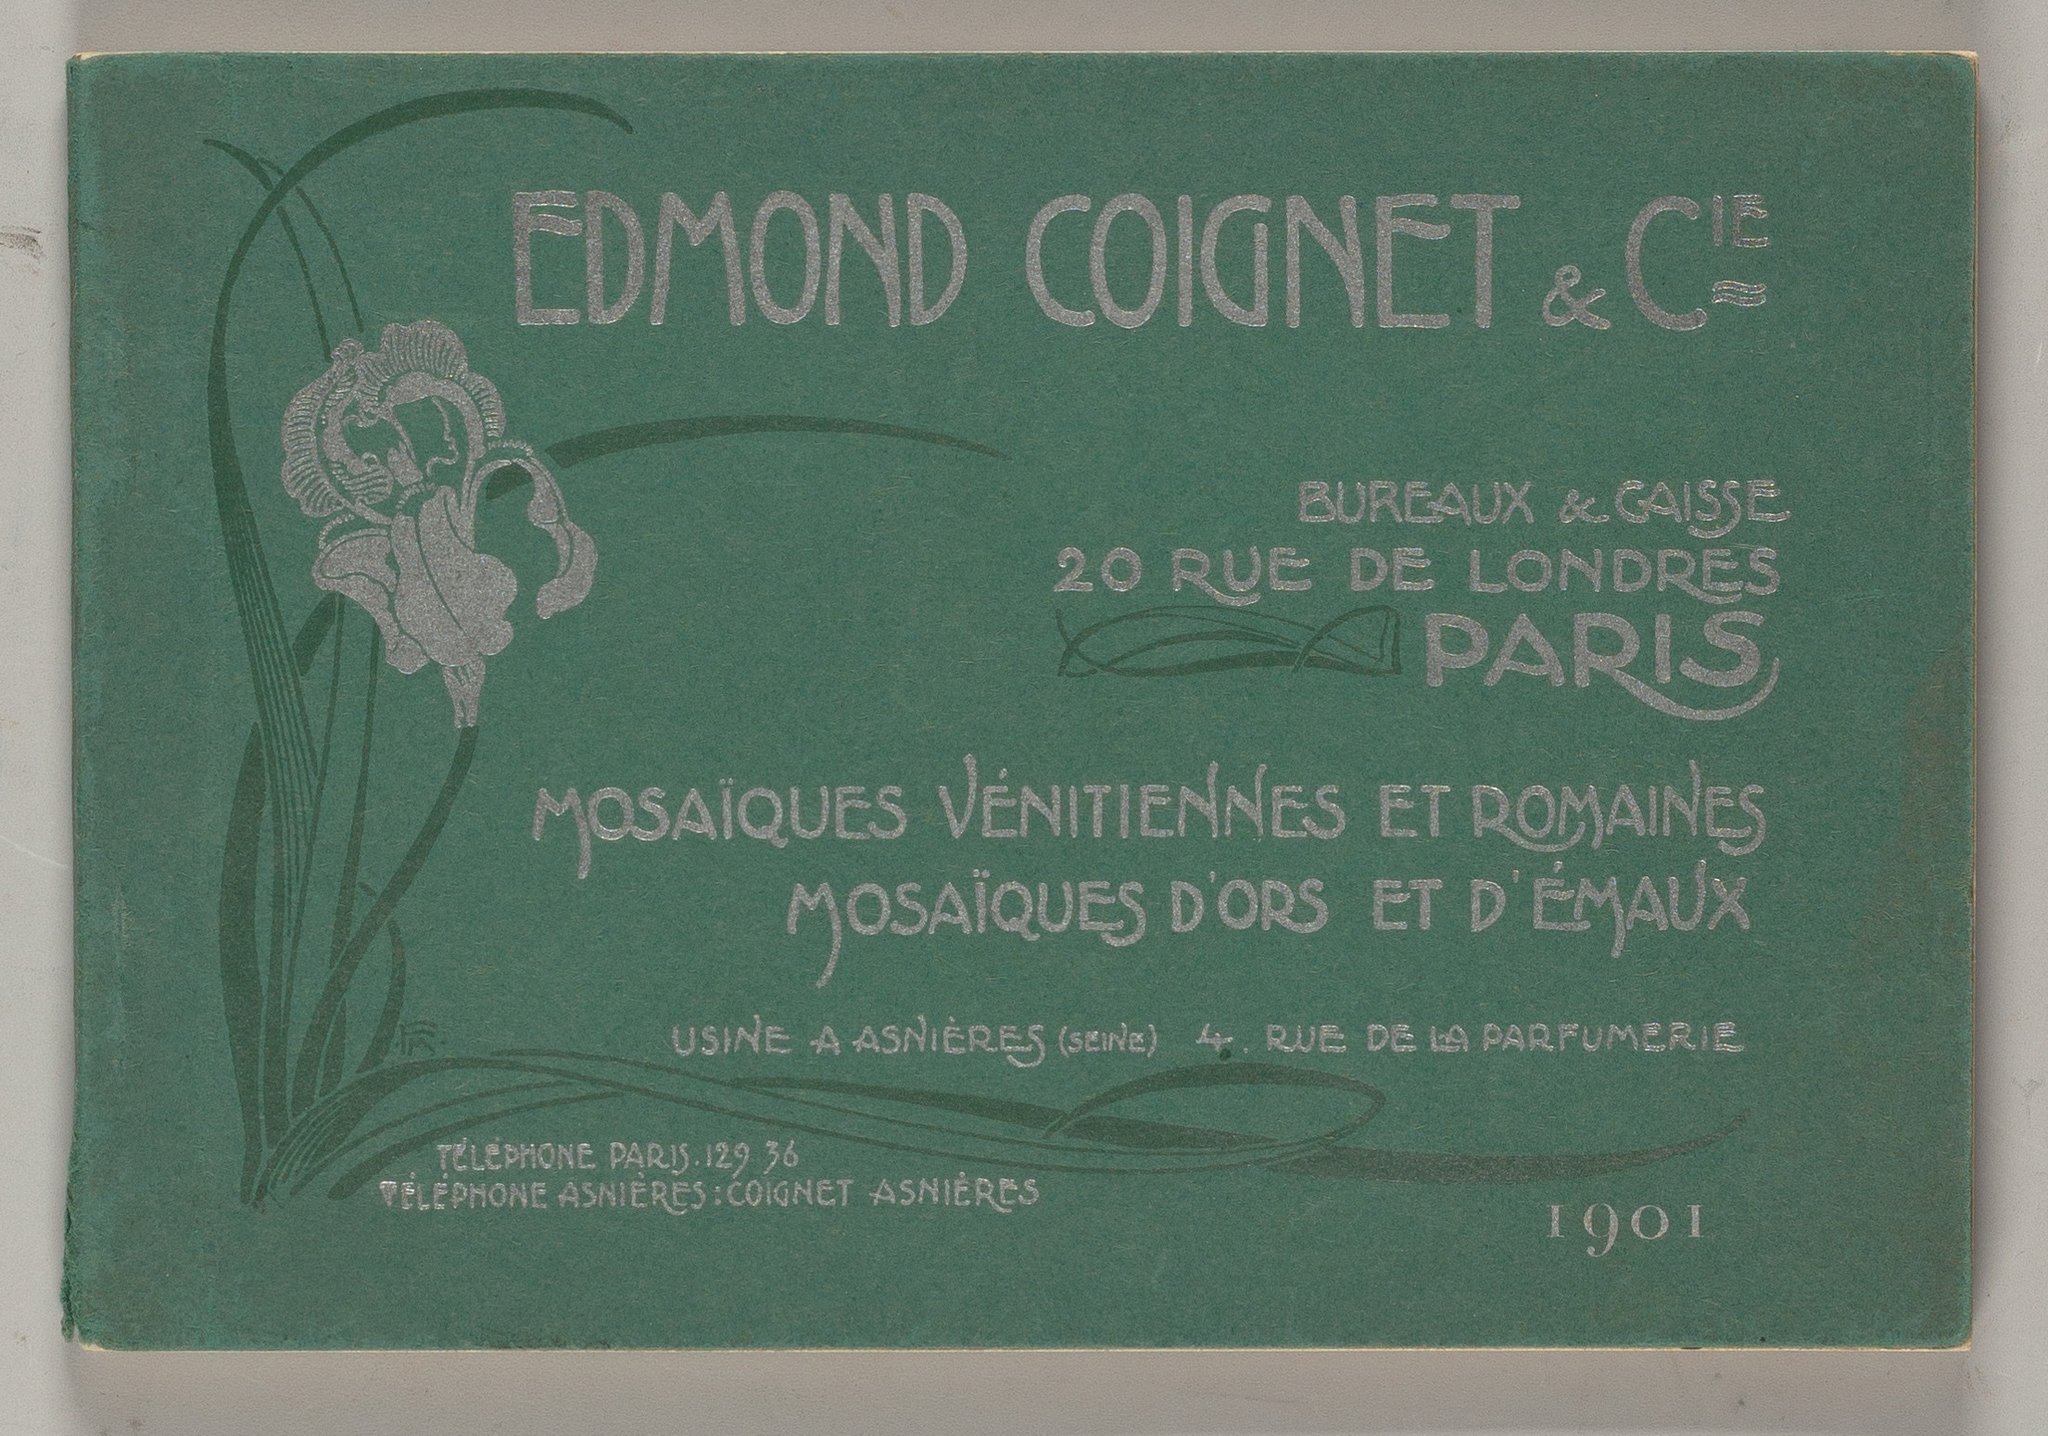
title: Carreaux mosaïques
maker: edmond coignet and cie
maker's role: author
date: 1901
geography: france